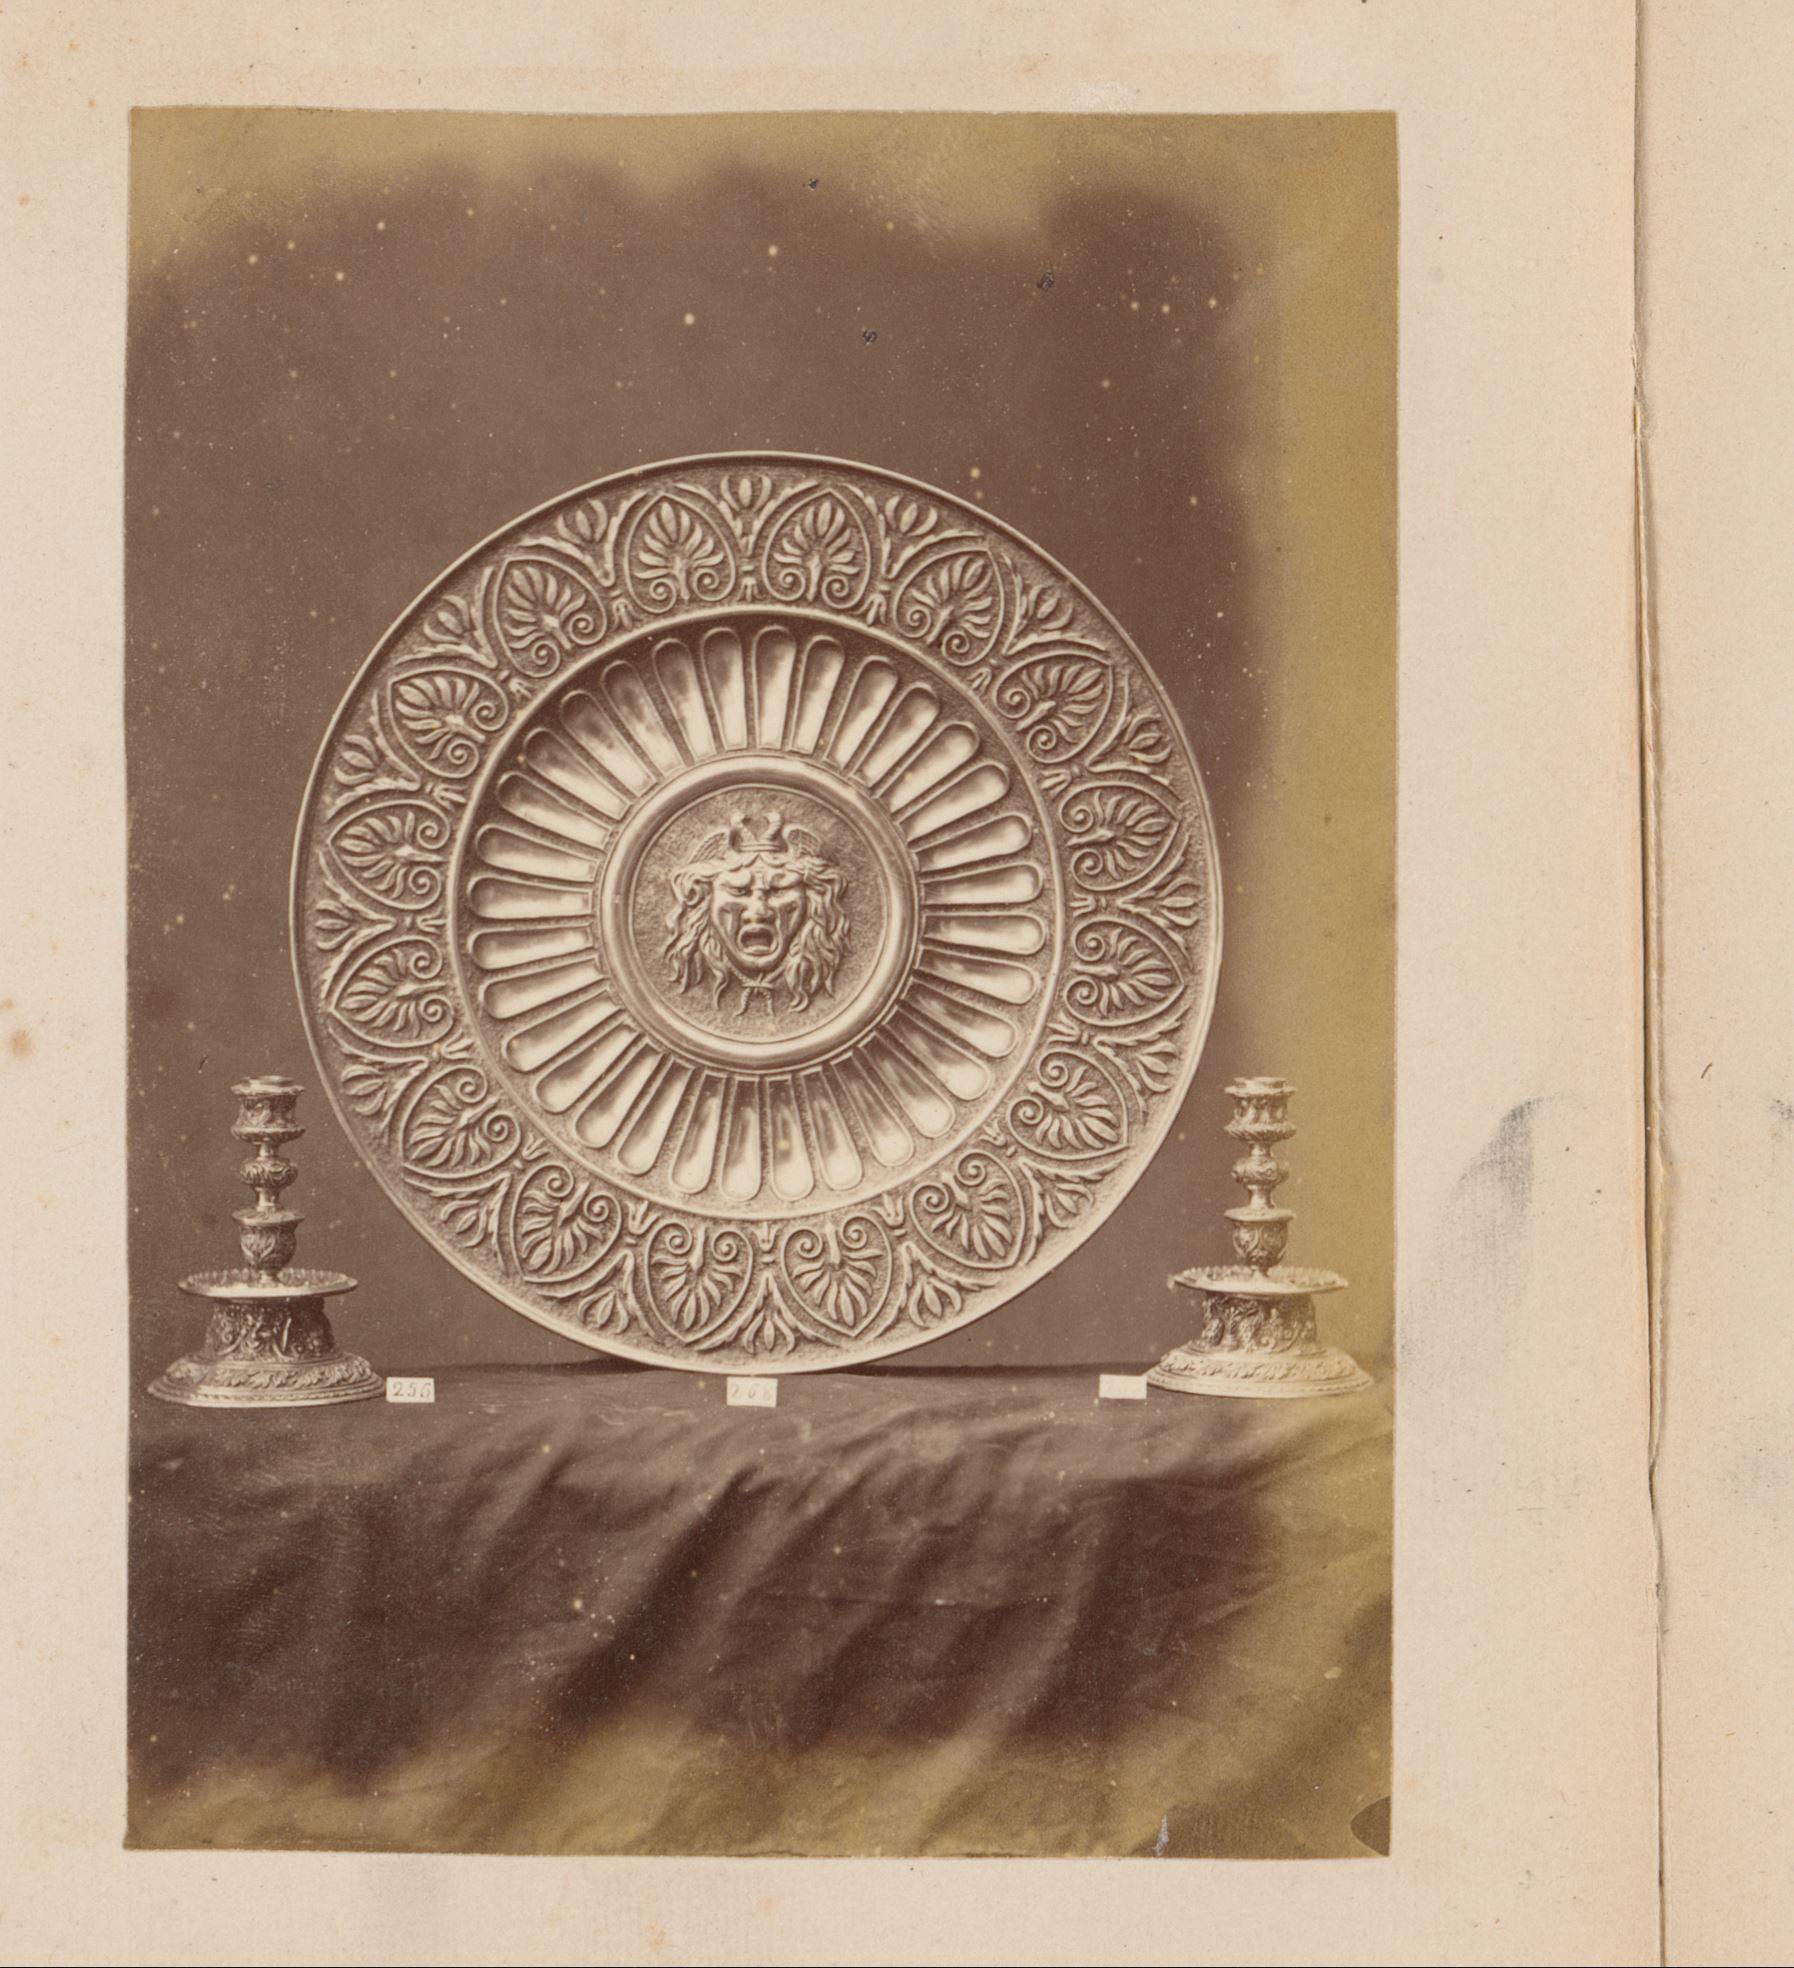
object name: page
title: Metalen bord en twee kandelaars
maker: Anonymous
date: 1860-1885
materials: photographic support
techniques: albumen print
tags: dish, plate, saucer, candlestick